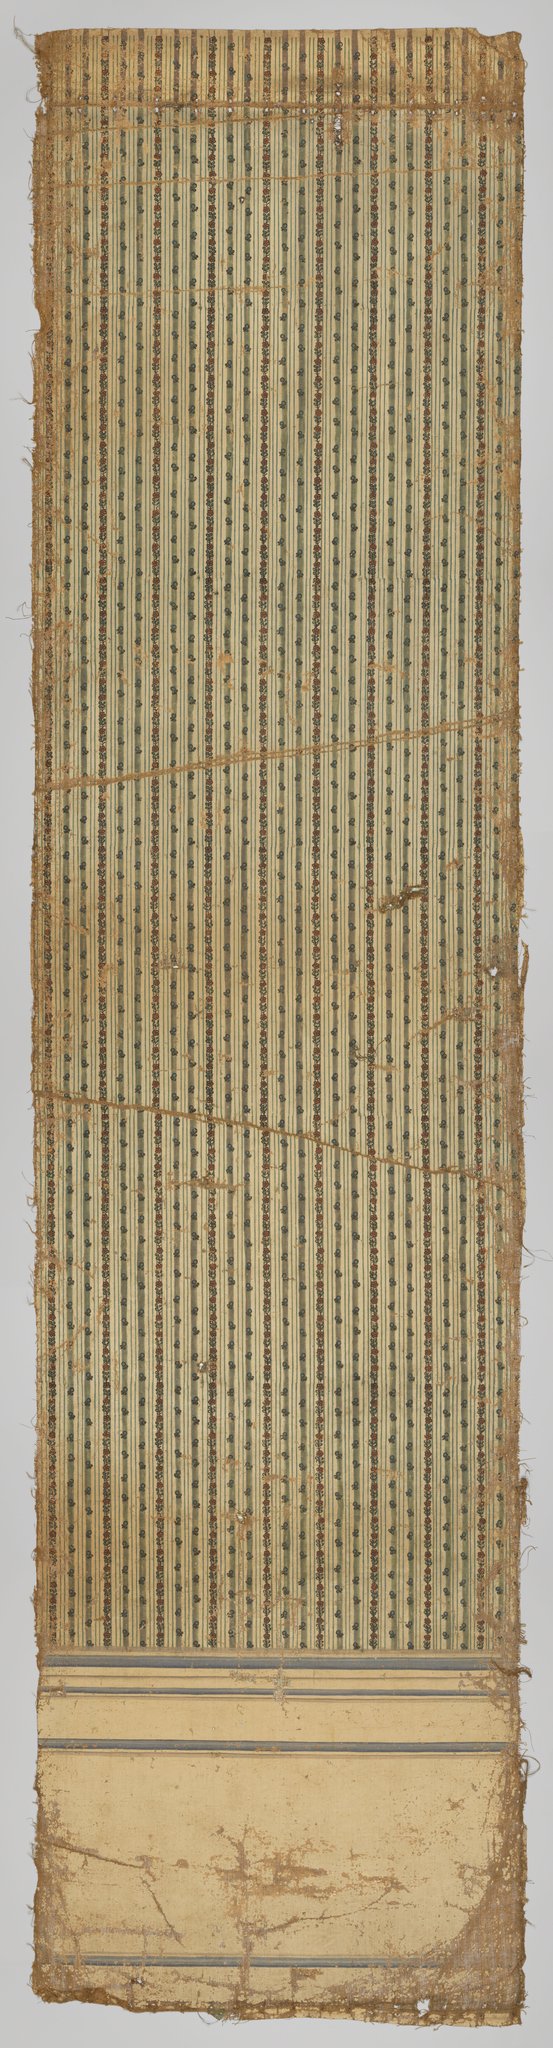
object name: hanging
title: Drie banen van op linnen geschilderd behangsel met verticale strepen afwisselend versierd met takken met bessen en een bloemenrank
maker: Anonymous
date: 1785-1800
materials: linen, oil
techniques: painted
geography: netherlands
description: Drie banen in olieverf op linnen geschilderd behangsel. Boven een lambris van gebroken wit met blauwgrijze omlijstingen, zijn op een gebroken wit fond grijsblauwe verticale strepen aangebracht, afwisselend versierd met gestrooide takjes met bessen en een bloemenrank in rood en blauw.